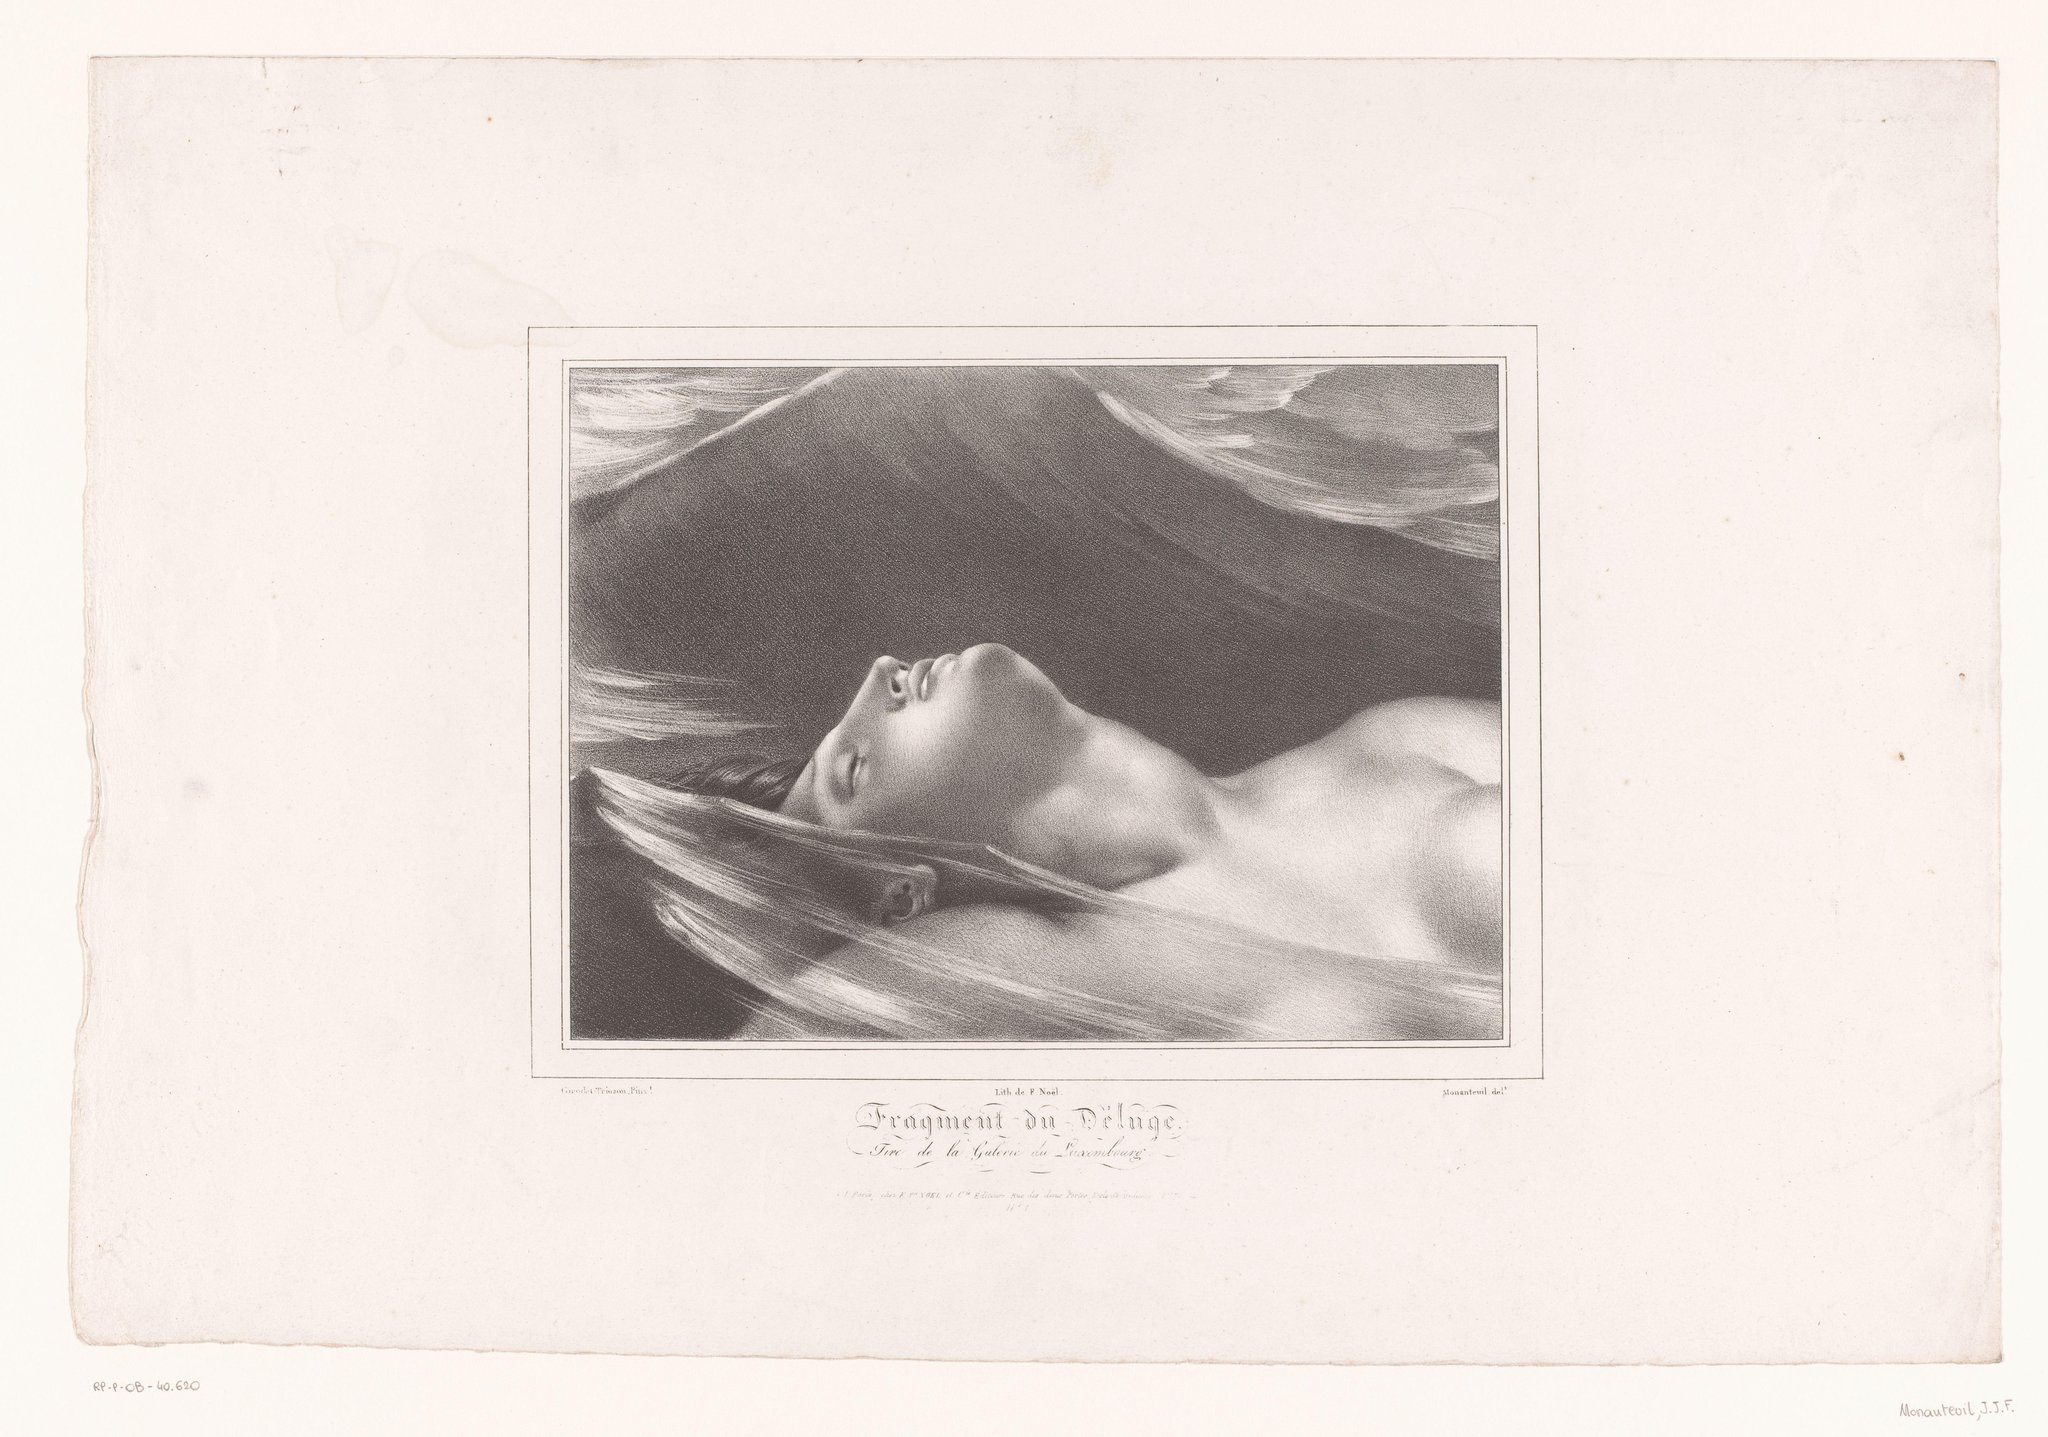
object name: print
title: Fragment du déluge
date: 1824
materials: paper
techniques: lithograph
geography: paris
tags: adult woman, the flood and destruction of mankind ~ story of noah (genesis 7:10 - 8:17)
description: Prent vermeld in: Bibliographie de la France (1824), nr. 32, 7 augustus 1824, p. 484.